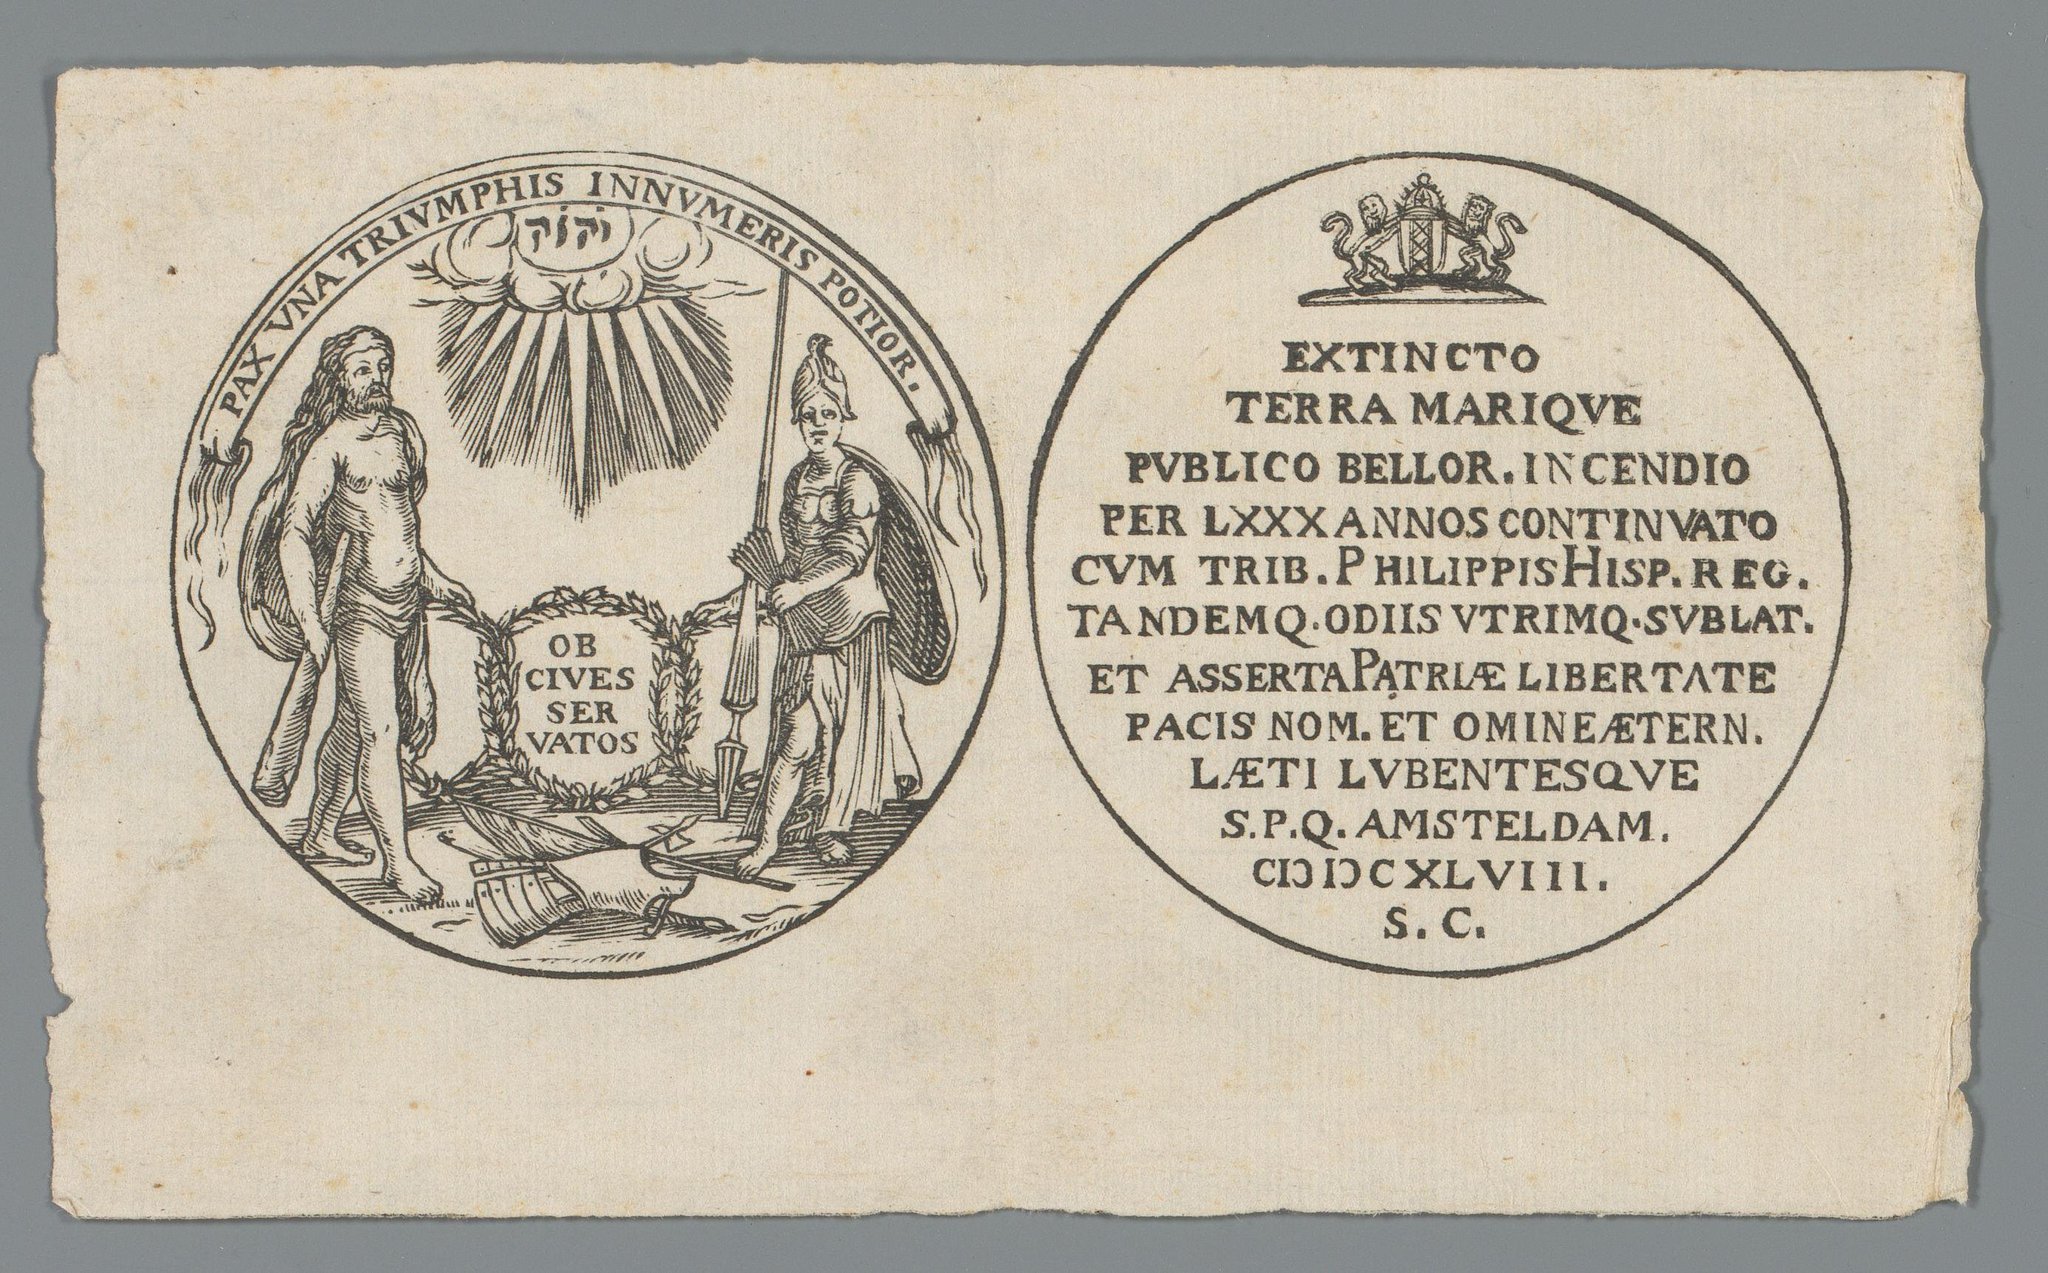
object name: print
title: Voor- en achterzijde van een penning met een zinnebeeld en een gedicht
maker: Anonymous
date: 1690-1850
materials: paper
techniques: woodcut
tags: politician, e.g. party leader, coin, freedom, liberty; 'libertà' (ripa)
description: Prent voor het eerst uitgegeven in: Bizot, Pierre. Medalische historie der republyk van Holland. Amsterdam: Pieter Mortier, 1690, dl. 1.